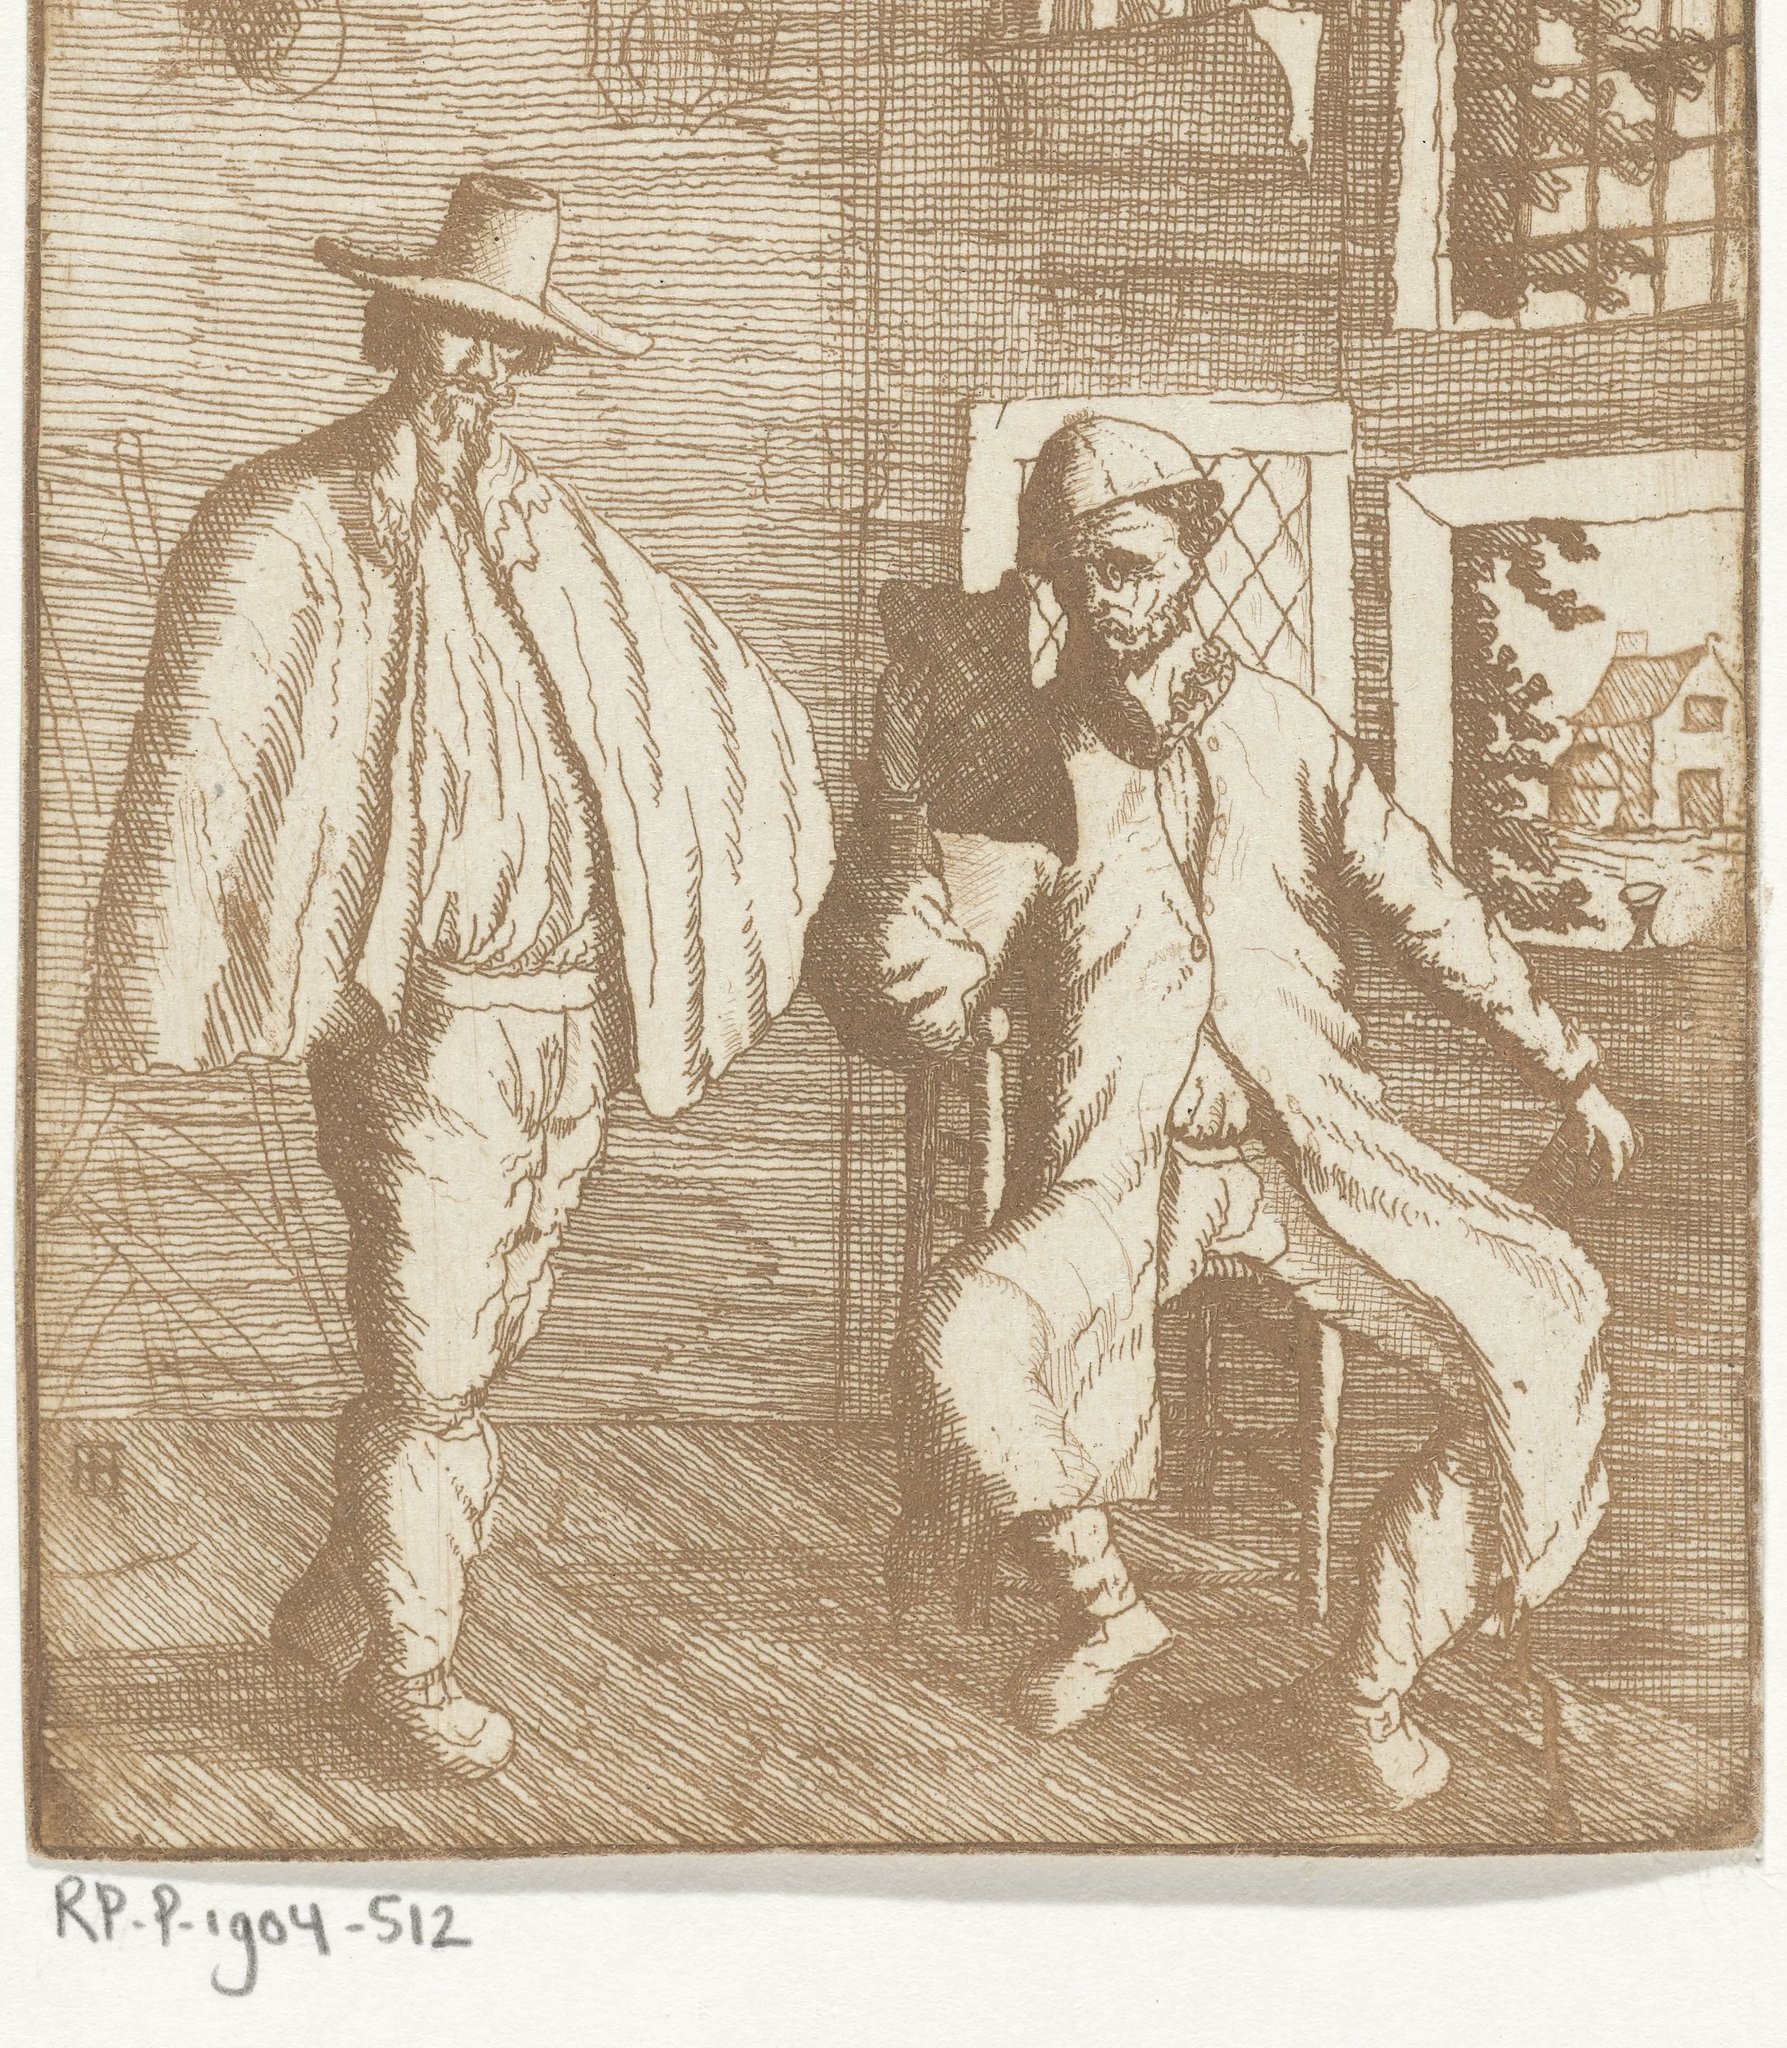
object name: print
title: Twee mannen in een interieur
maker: james hazard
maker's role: print maker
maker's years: 1748-1787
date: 1758-1787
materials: paper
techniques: etching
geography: southern netherlands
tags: interior of the house, paper (writing material)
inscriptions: collector's mark: Lugt 2228